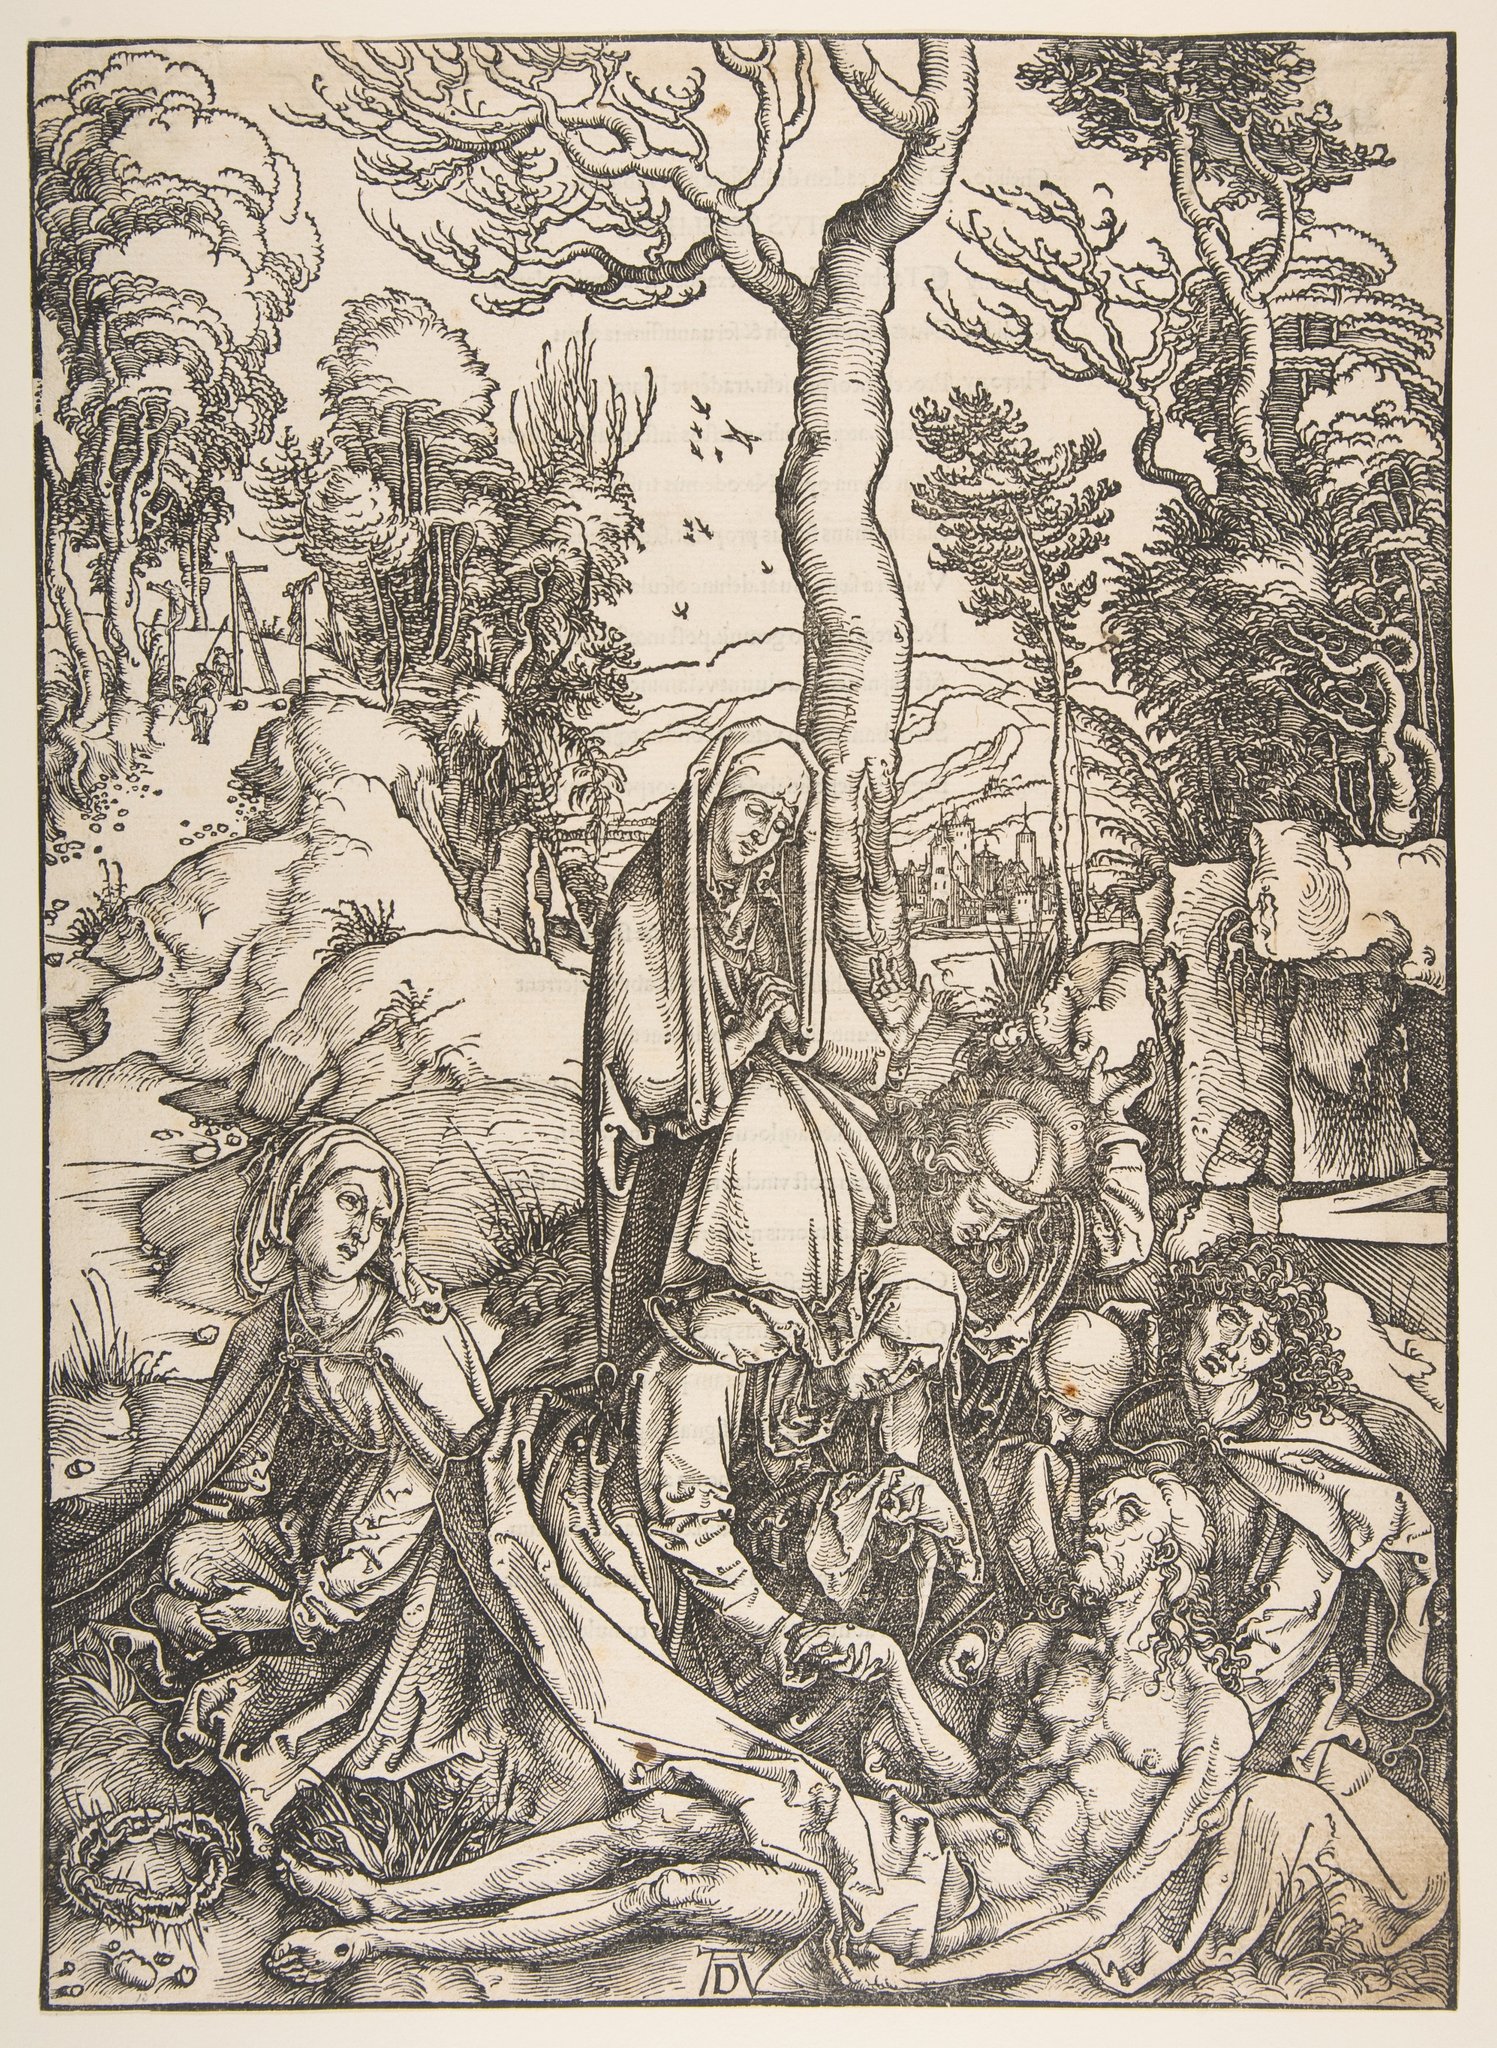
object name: print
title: The Lamentation for Christ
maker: albrecht dürer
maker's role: artist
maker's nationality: german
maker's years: 1471-1528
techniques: woodcut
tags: sadness,women,christ,lamentation